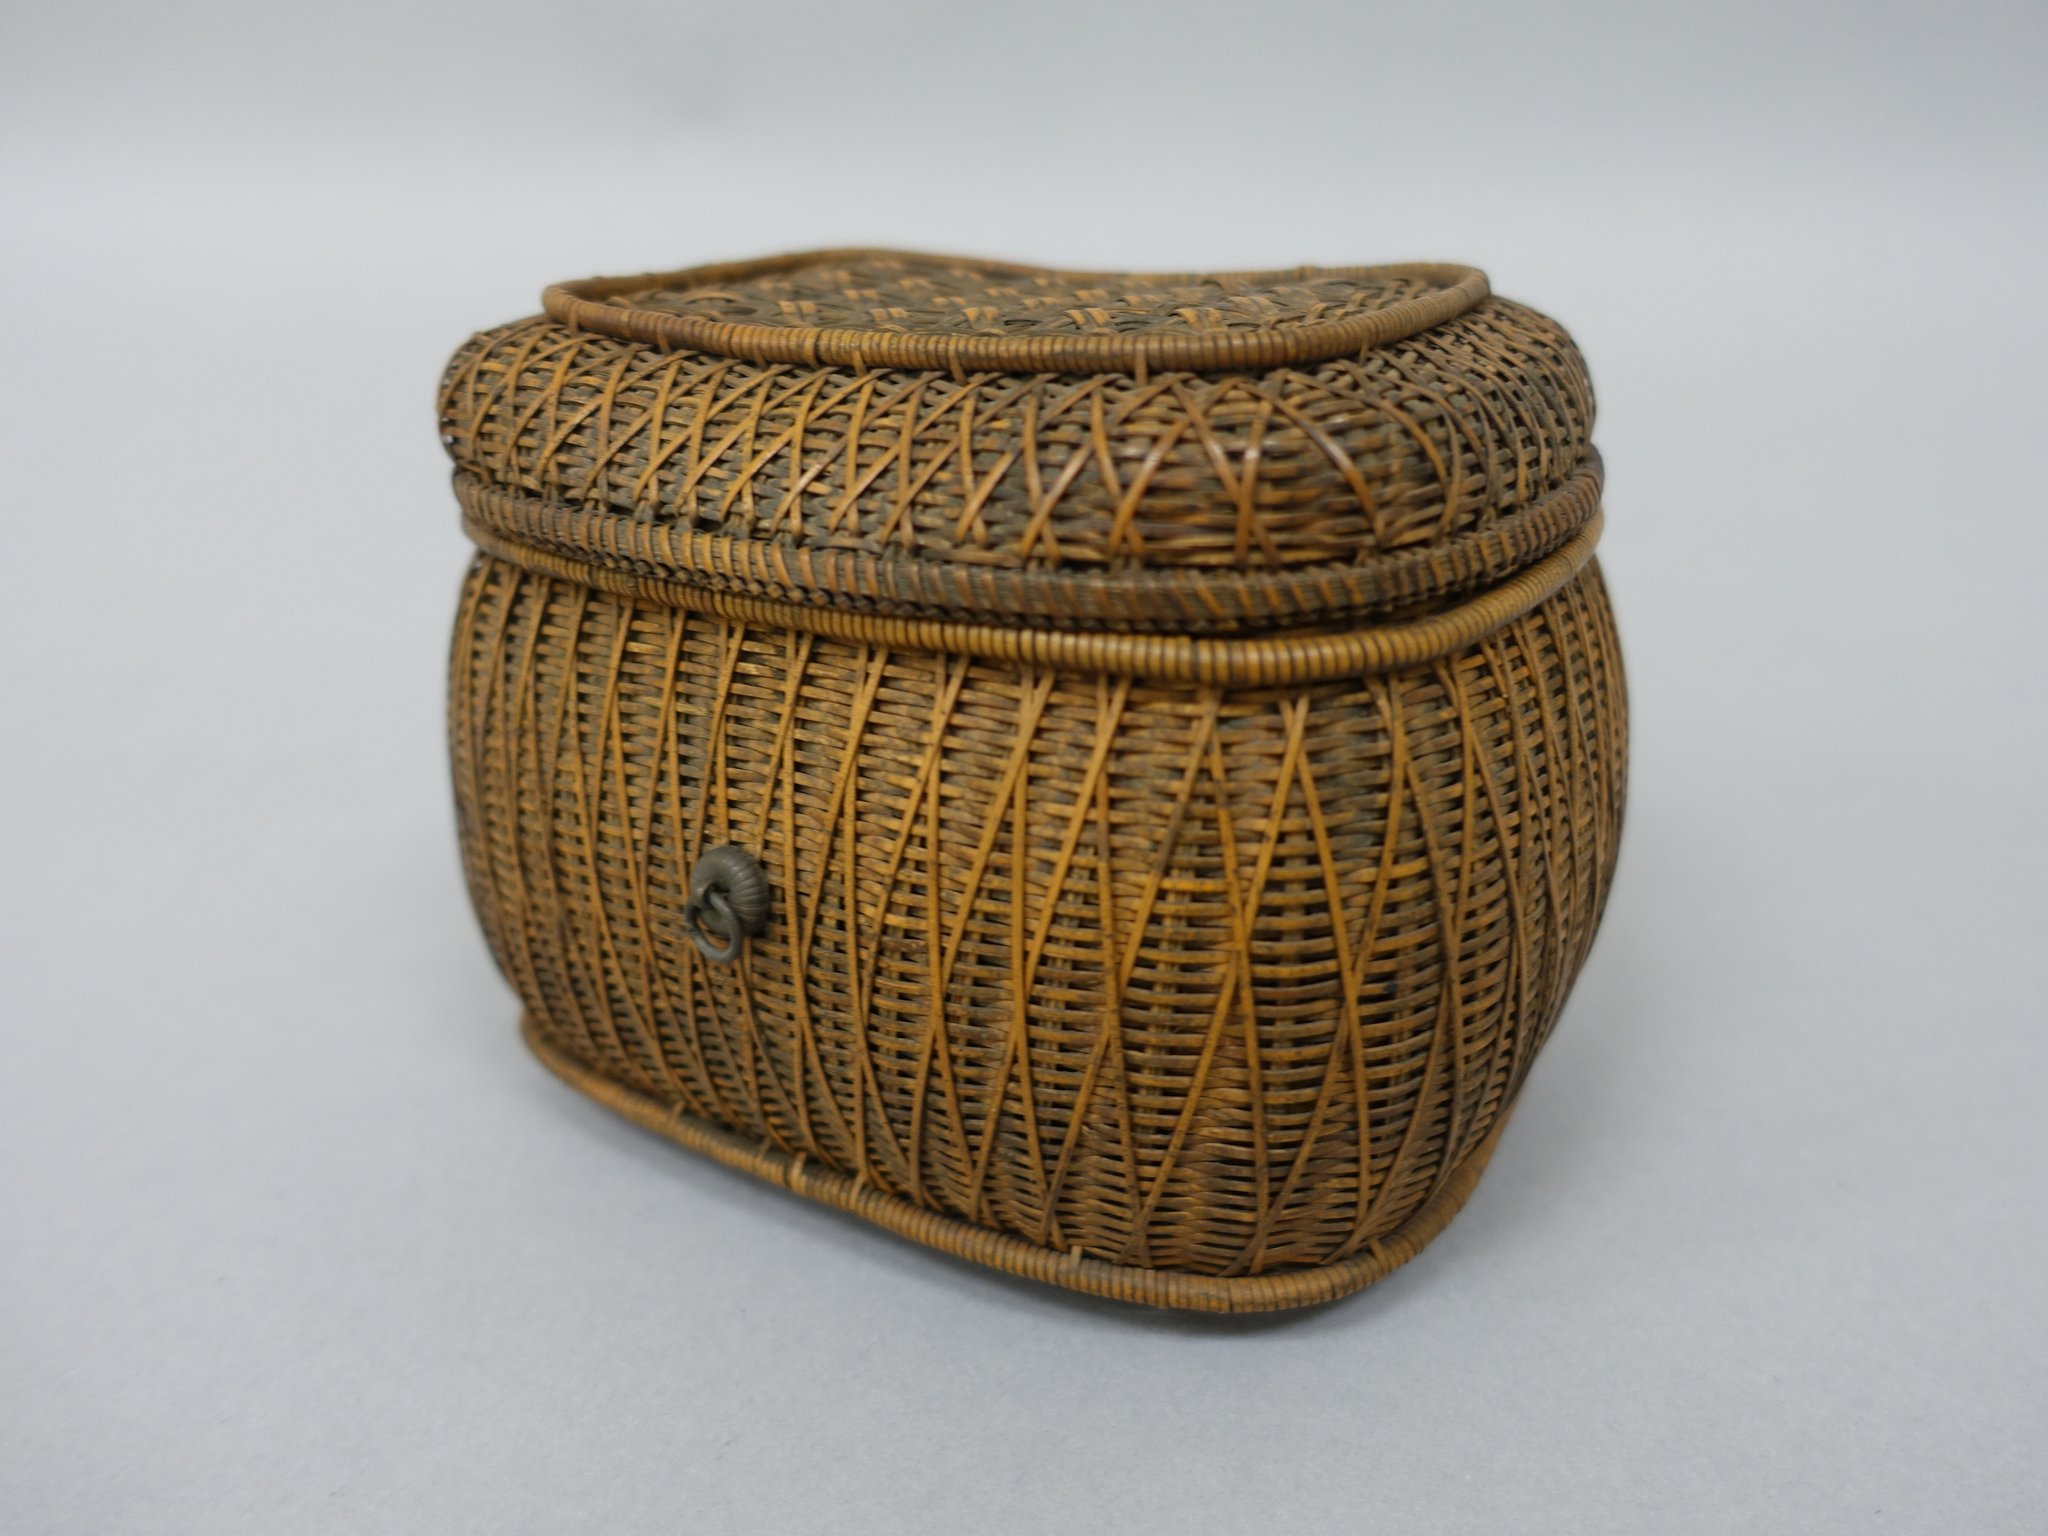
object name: covered basket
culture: japanese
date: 1801-1900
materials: bamboo